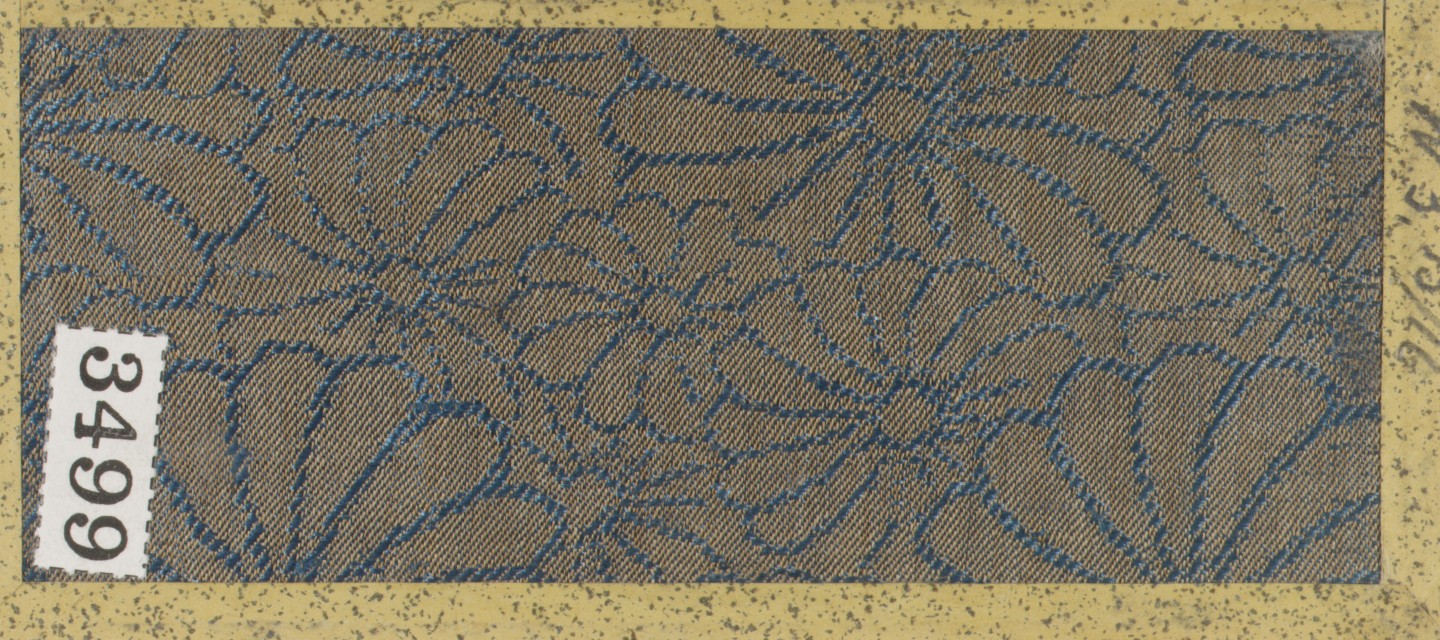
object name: sample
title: Textile Sample from Sample Book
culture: japanese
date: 1801-1900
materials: silk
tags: flowers